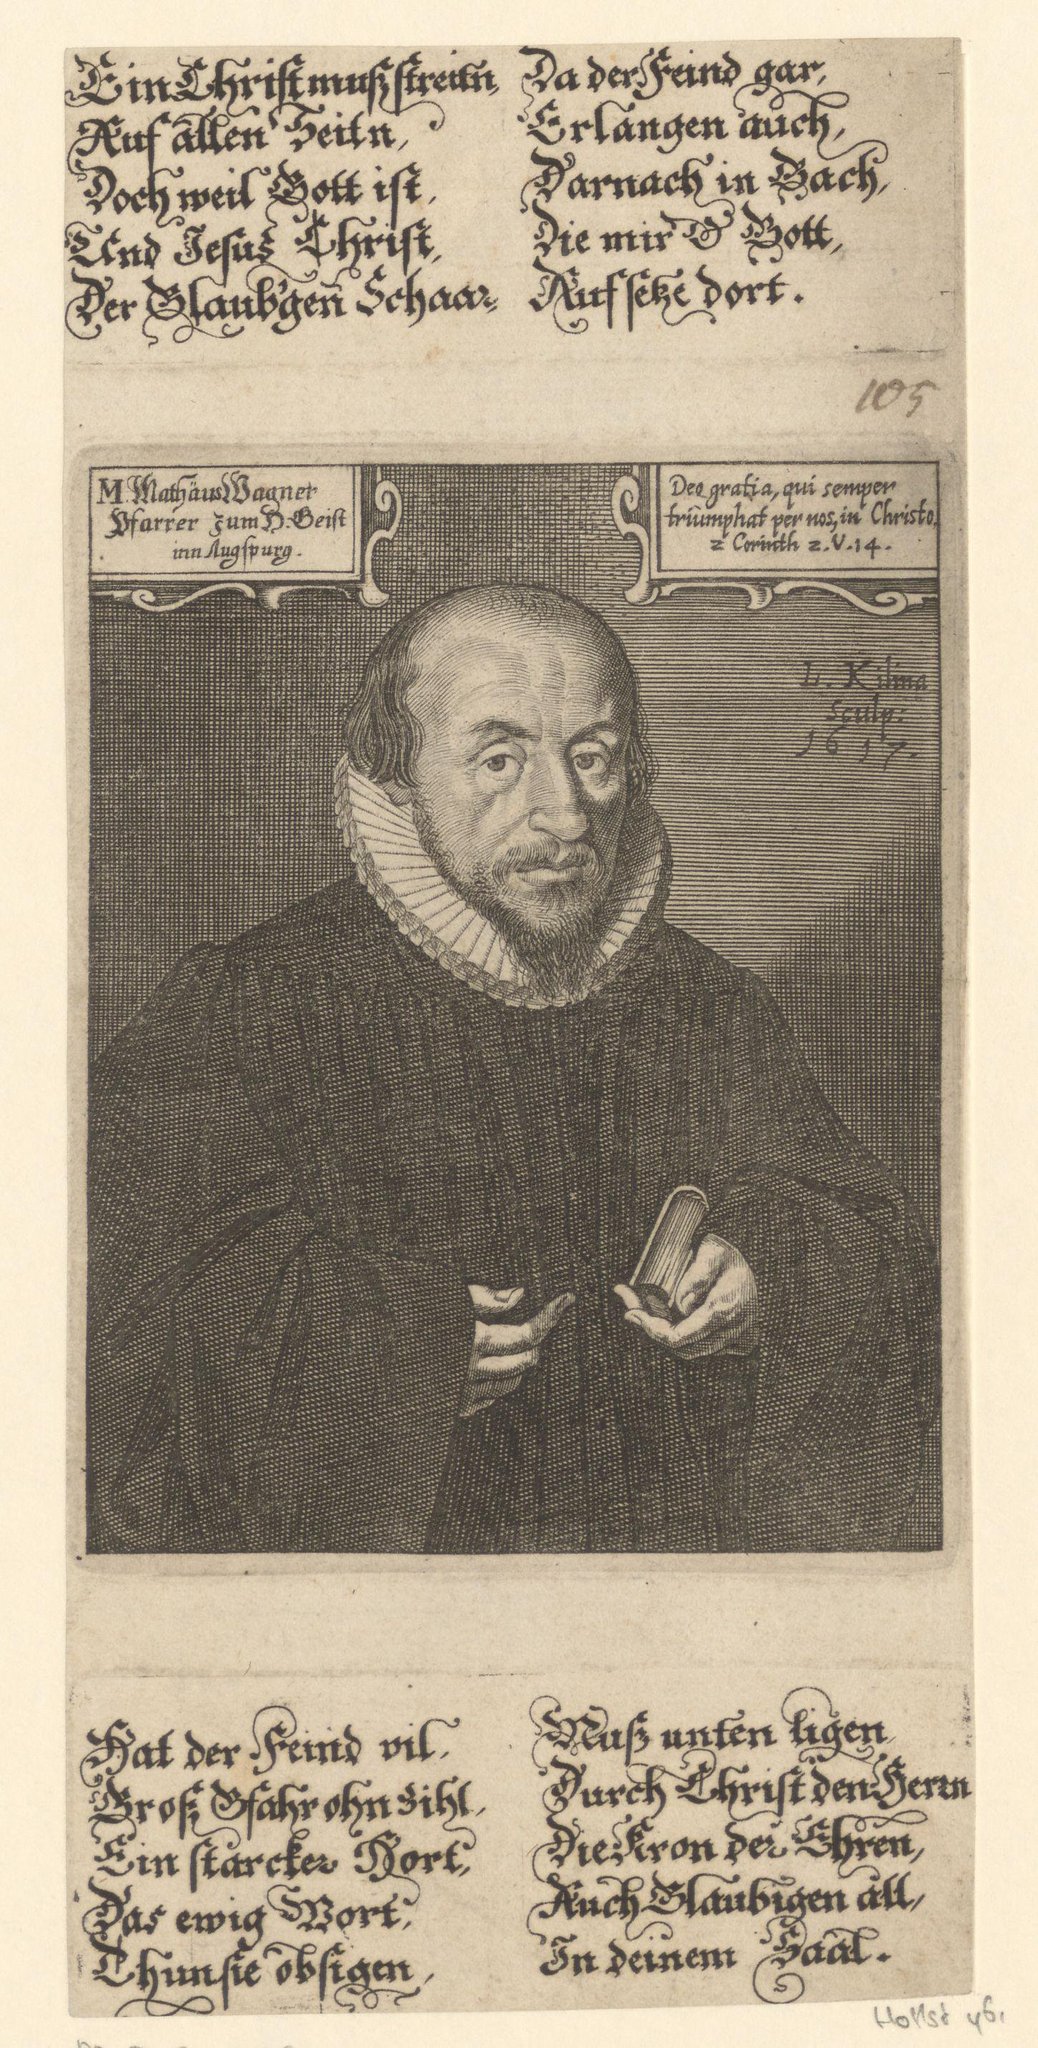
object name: print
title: Portret van Matthäus Wagner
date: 1617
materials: paper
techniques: engraving, letterpress printing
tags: augsburg, theologian, historical persons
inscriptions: collector's mark: Lugt 2228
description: Tekst in het Latijn in de kaders. Tekst in het Duits in boekdruk op het blad.